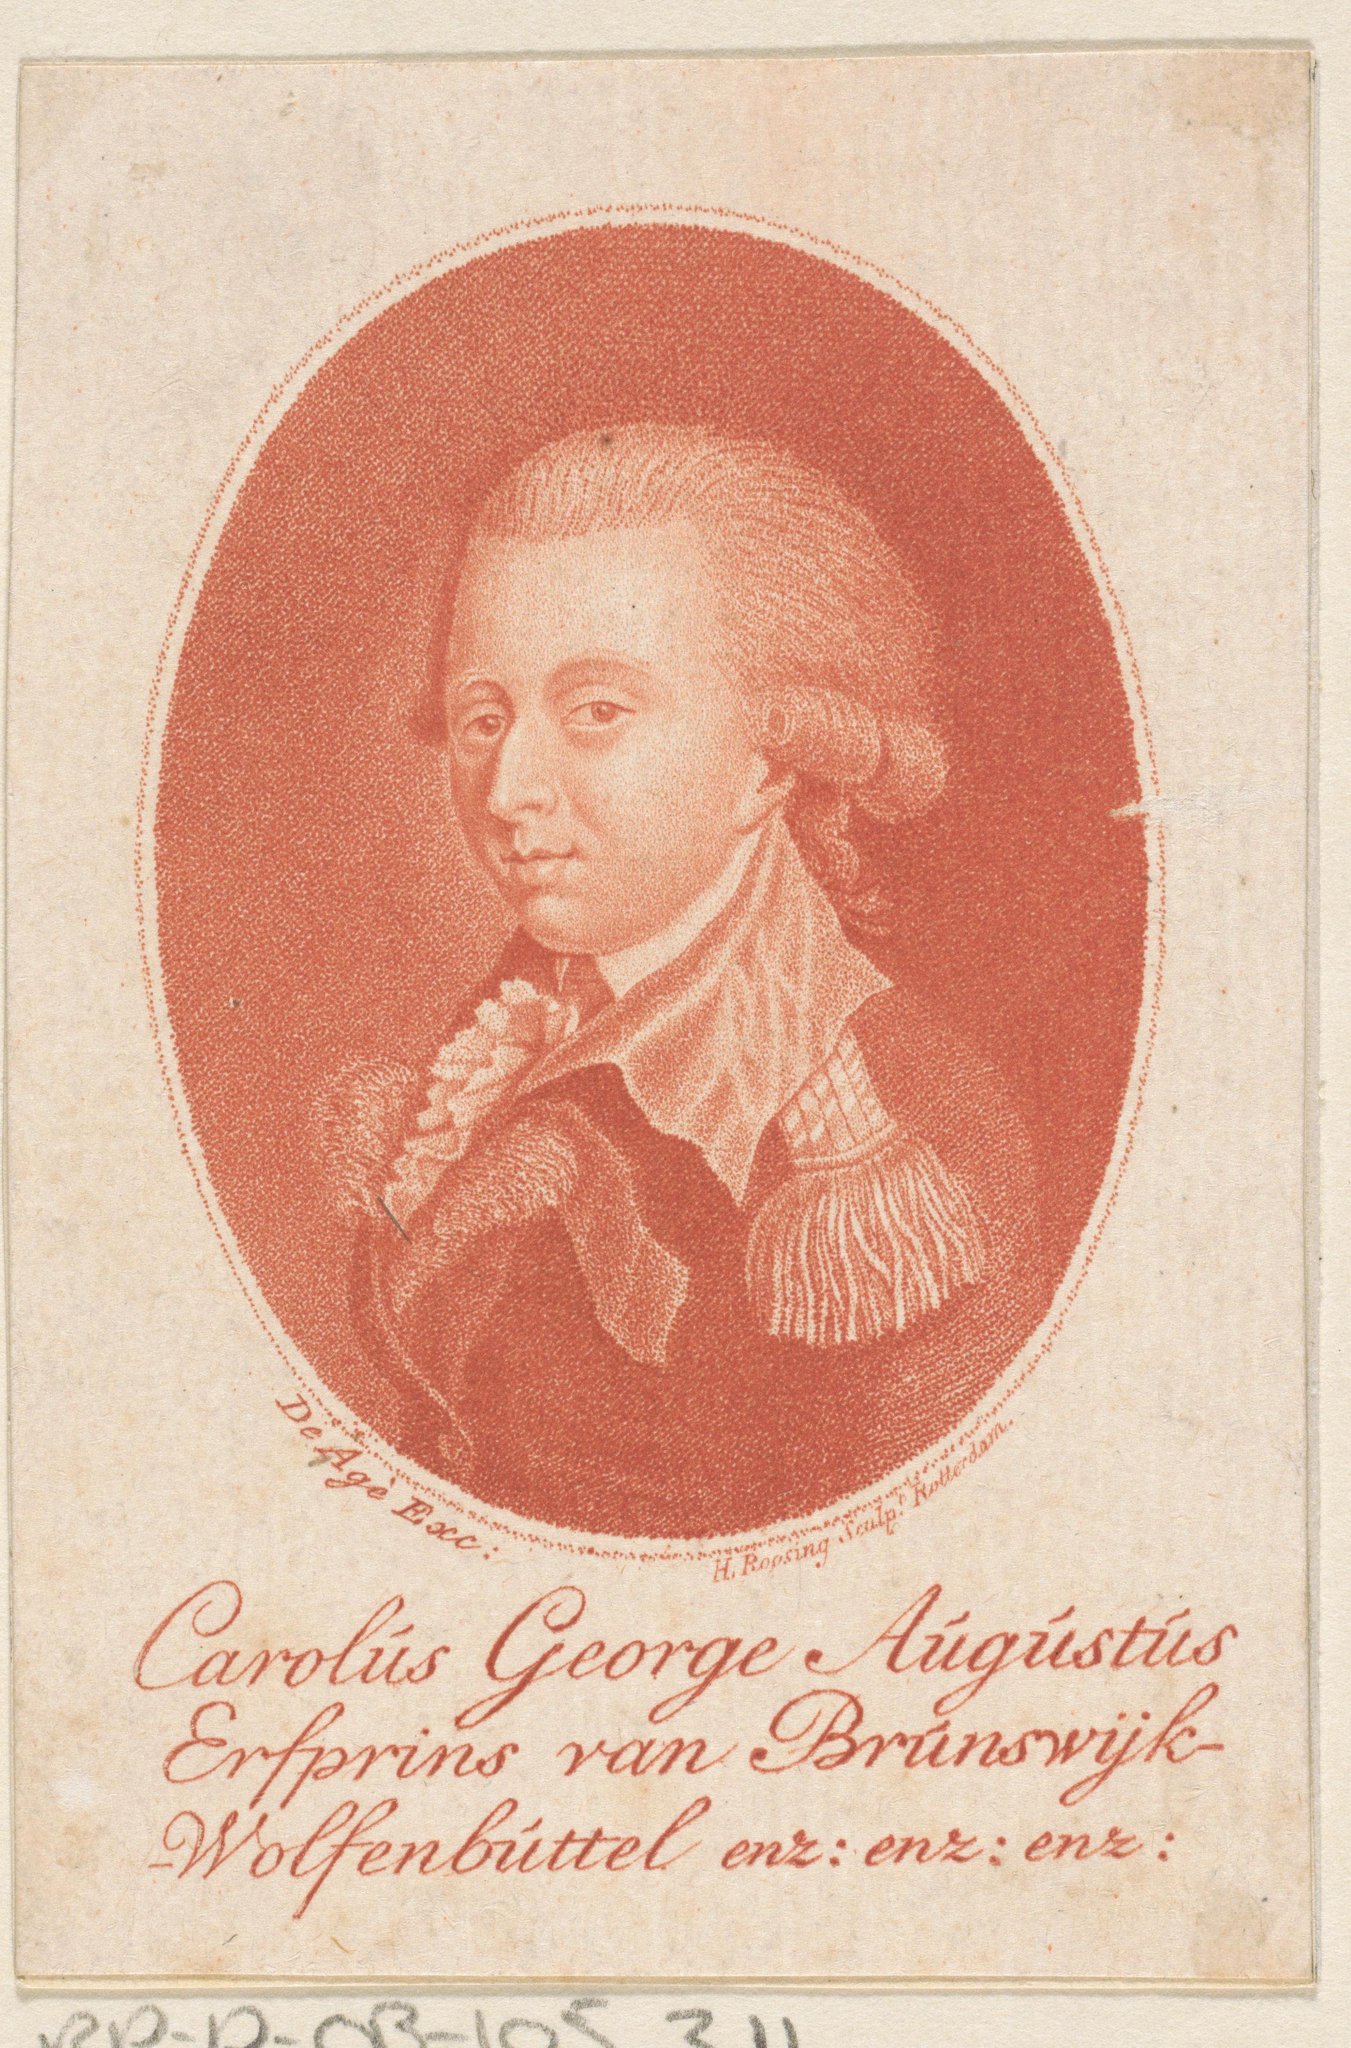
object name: print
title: Portret van Karel van Brunswijk-Wolfenbüttel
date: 1785-1801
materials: paper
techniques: engraving, etching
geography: the hague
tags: karel van brunswijk-wolfenbüttel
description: Portret van Karel in een ovaal. In de ondermarge zijn naam en titels.